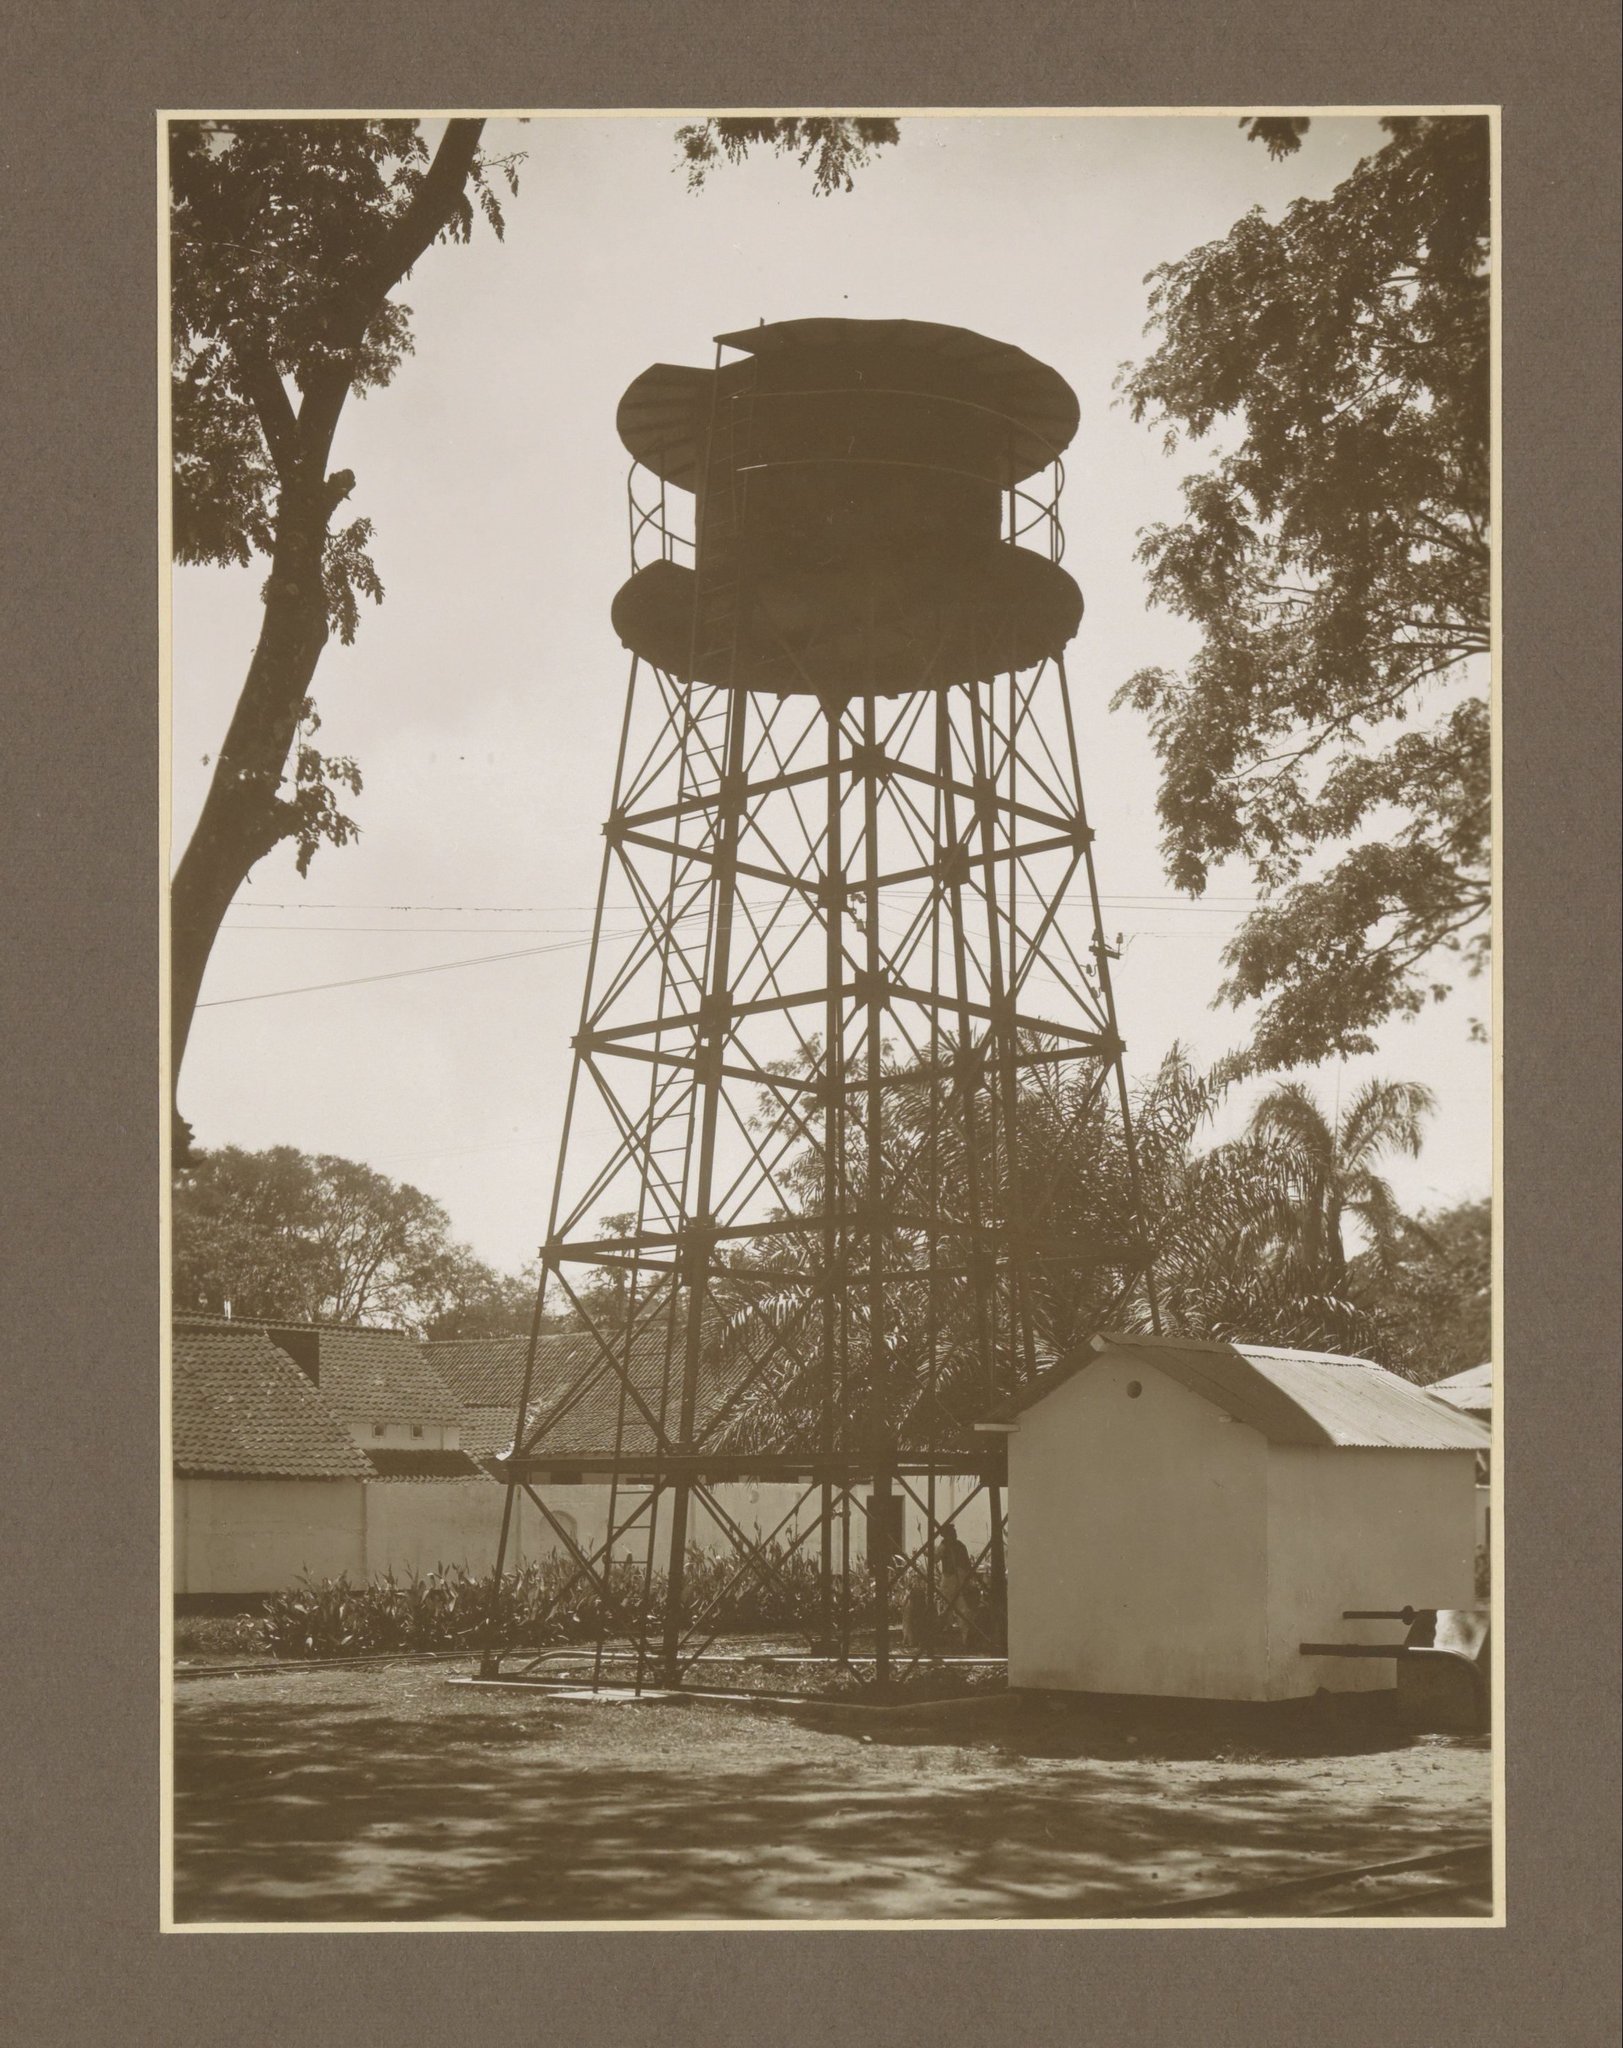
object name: photograph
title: Sf. Ngandjoek Watertoren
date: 1925-1930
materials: cardboard, paper, photographic support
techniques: gelatin silver print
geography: nganjuk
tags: plantation, water tower, plants and herbs: sugarcane, sugar, dutch east indies, the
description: Onderdeel van Fotoalbum met opnames van vier suikerfabrieken op Java.